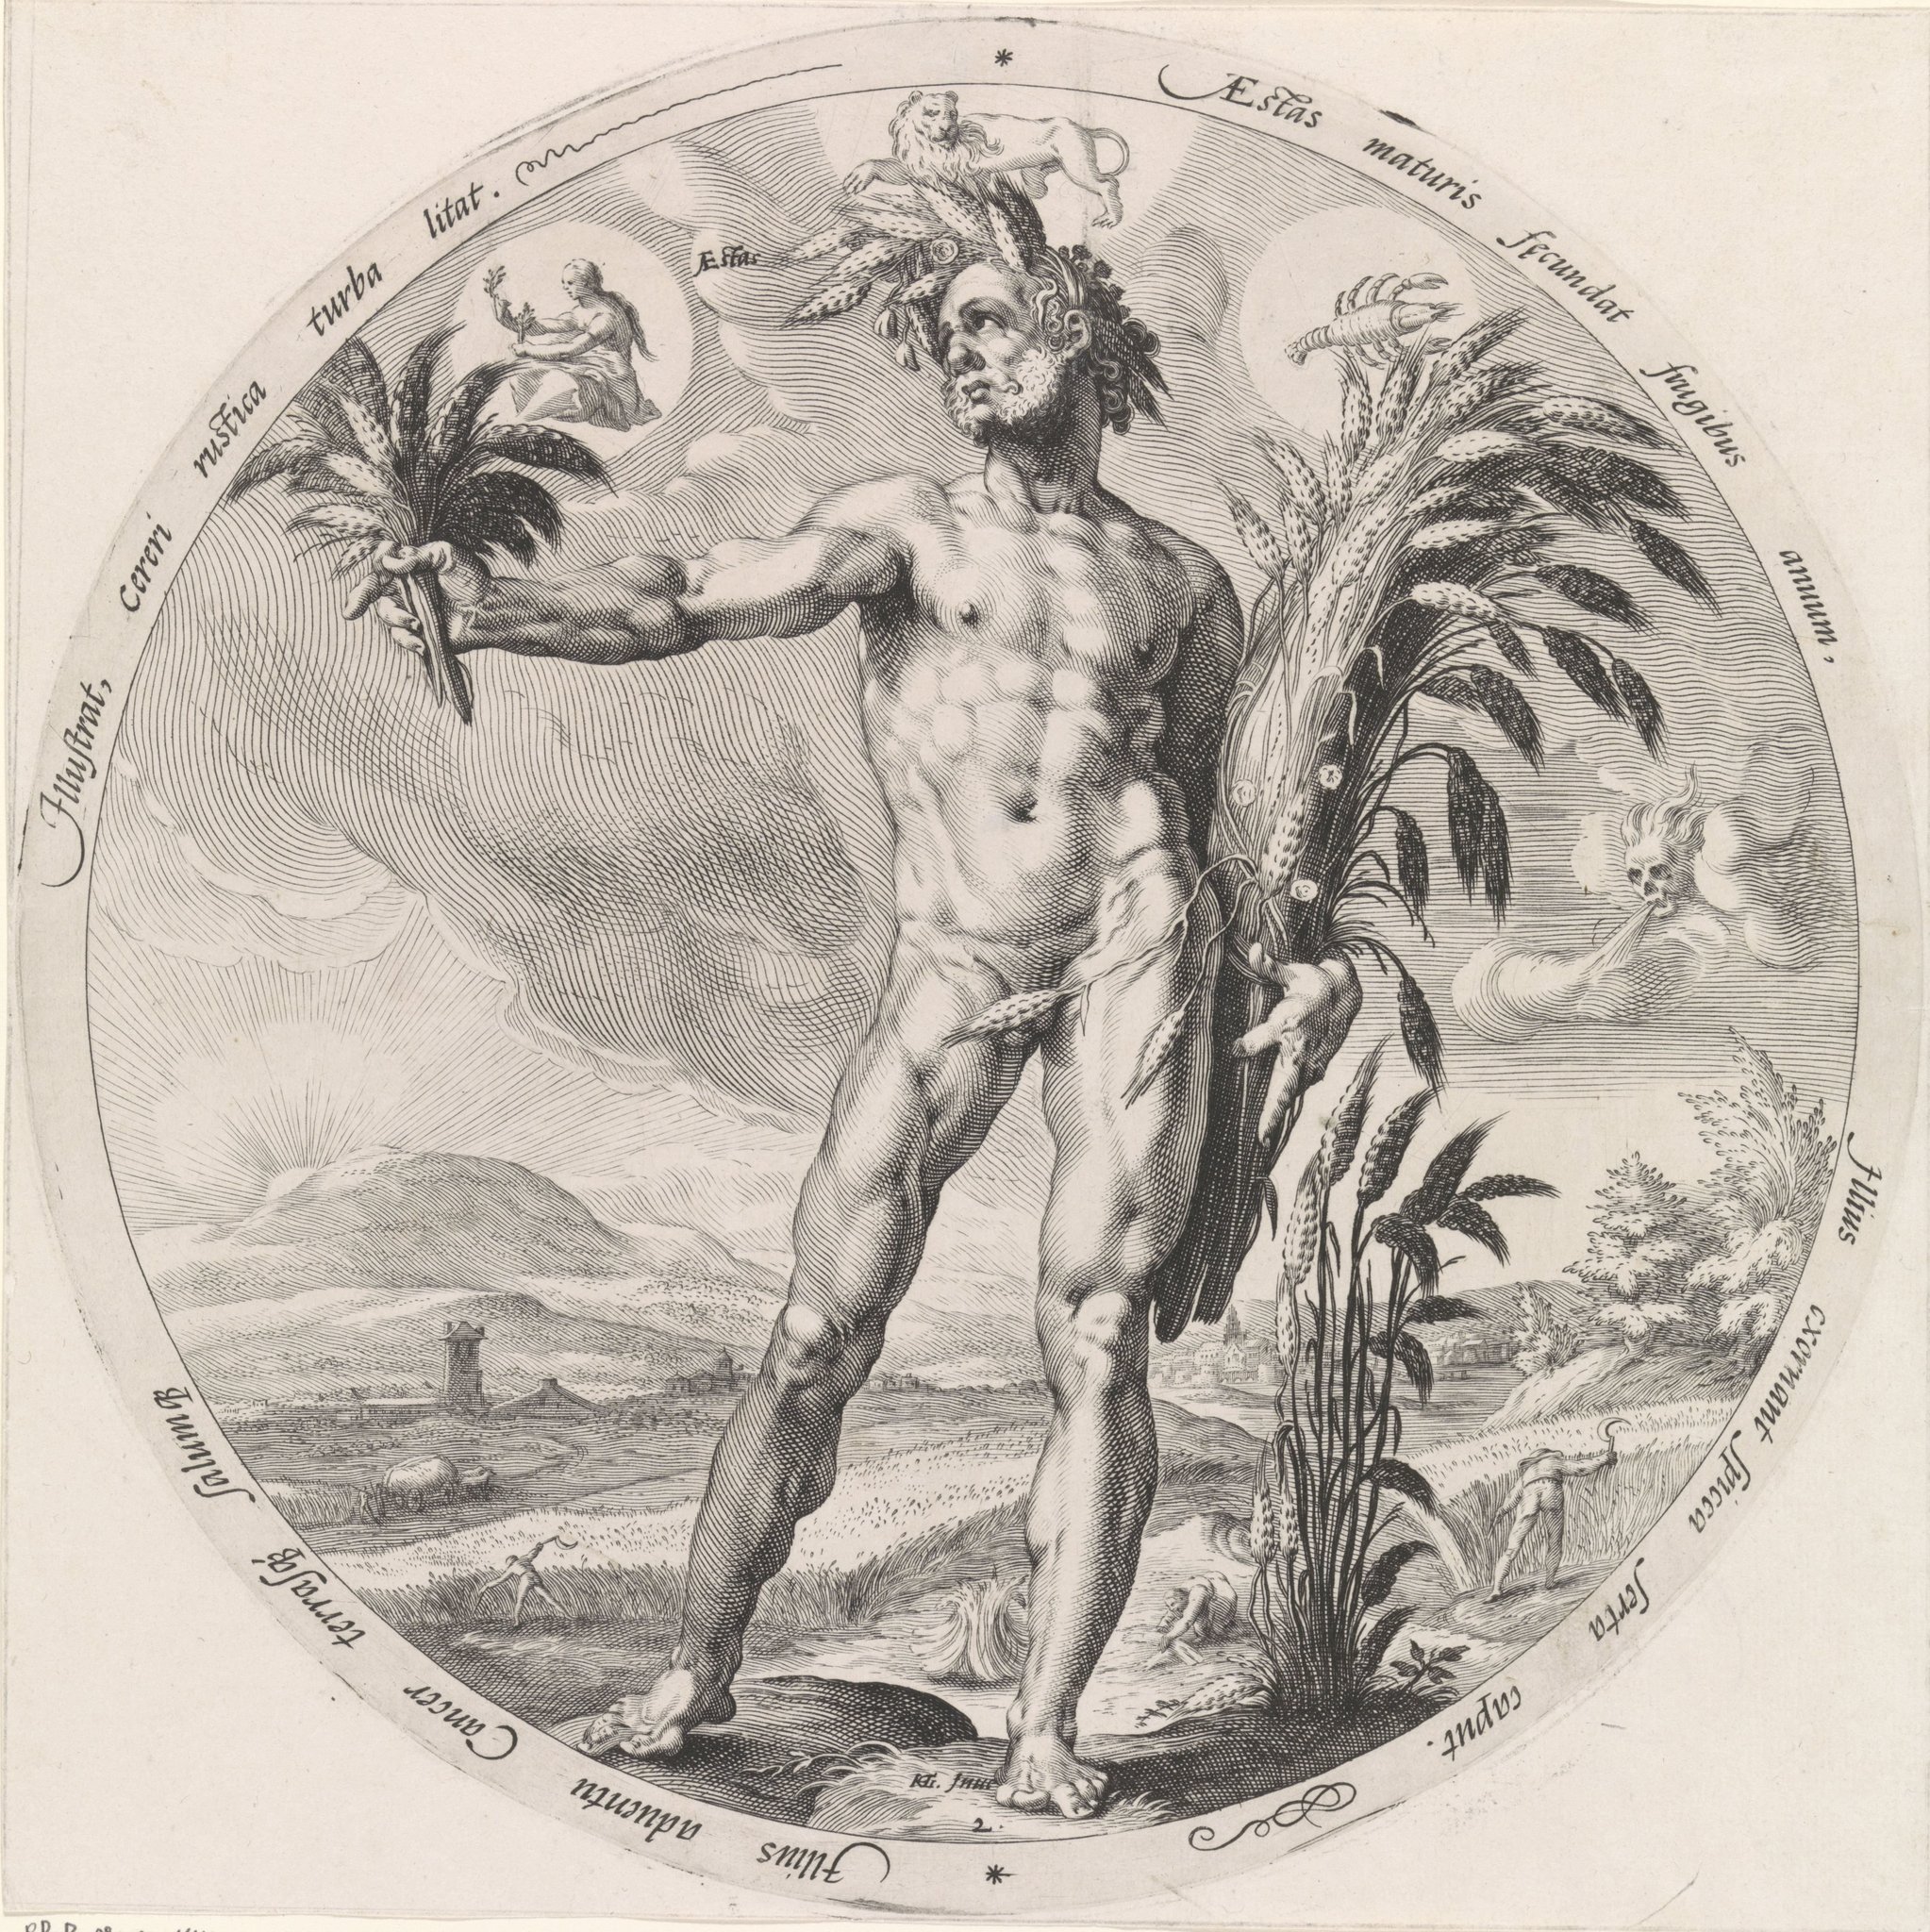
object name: print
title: Aestas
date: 1589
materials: paper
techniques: engraving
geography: haarlem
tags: summer, 'aestas'; 'estate' (ripa)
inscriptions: collector's mark: Lugt 240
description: Personificatie van de zomer: een staande man met korenschoven in een landschap. Op de achtergrond maaiende figuren en een zon half achter een heuvel. Bovenaan de bijbehorende tekens van de dierenriem: Maagd, Leeuw en Kreeft.